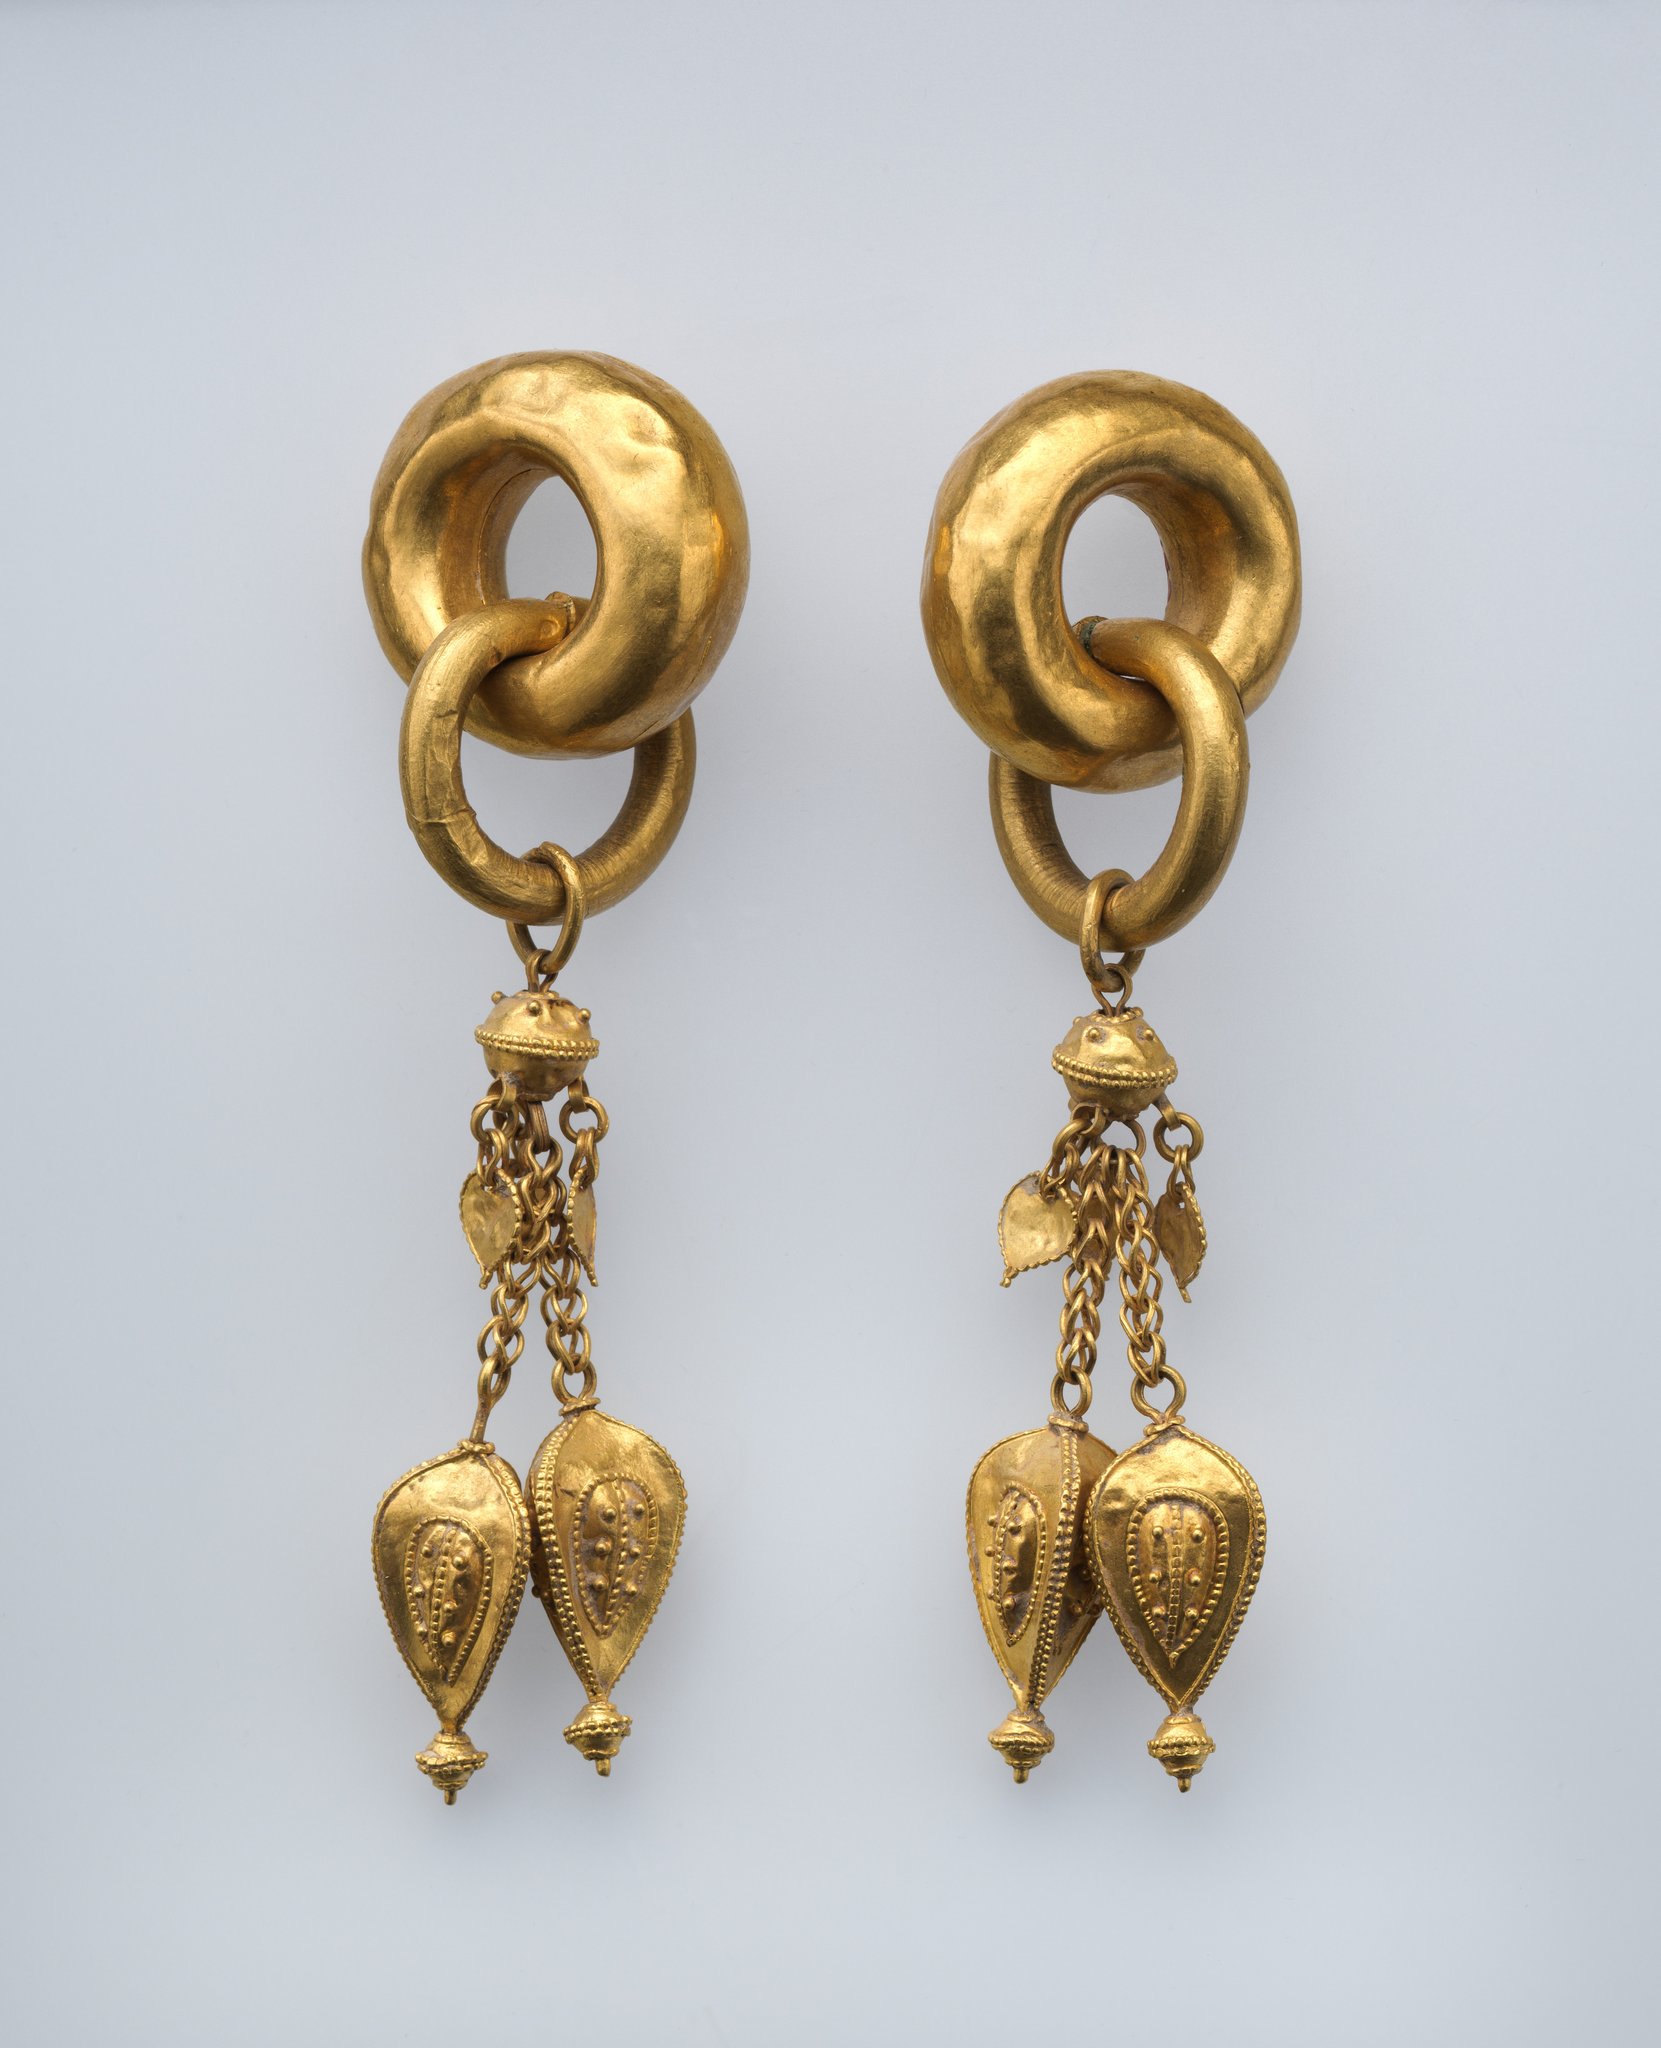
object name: earring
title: Earring (one of a pair)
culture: korean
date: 501-600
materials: gold